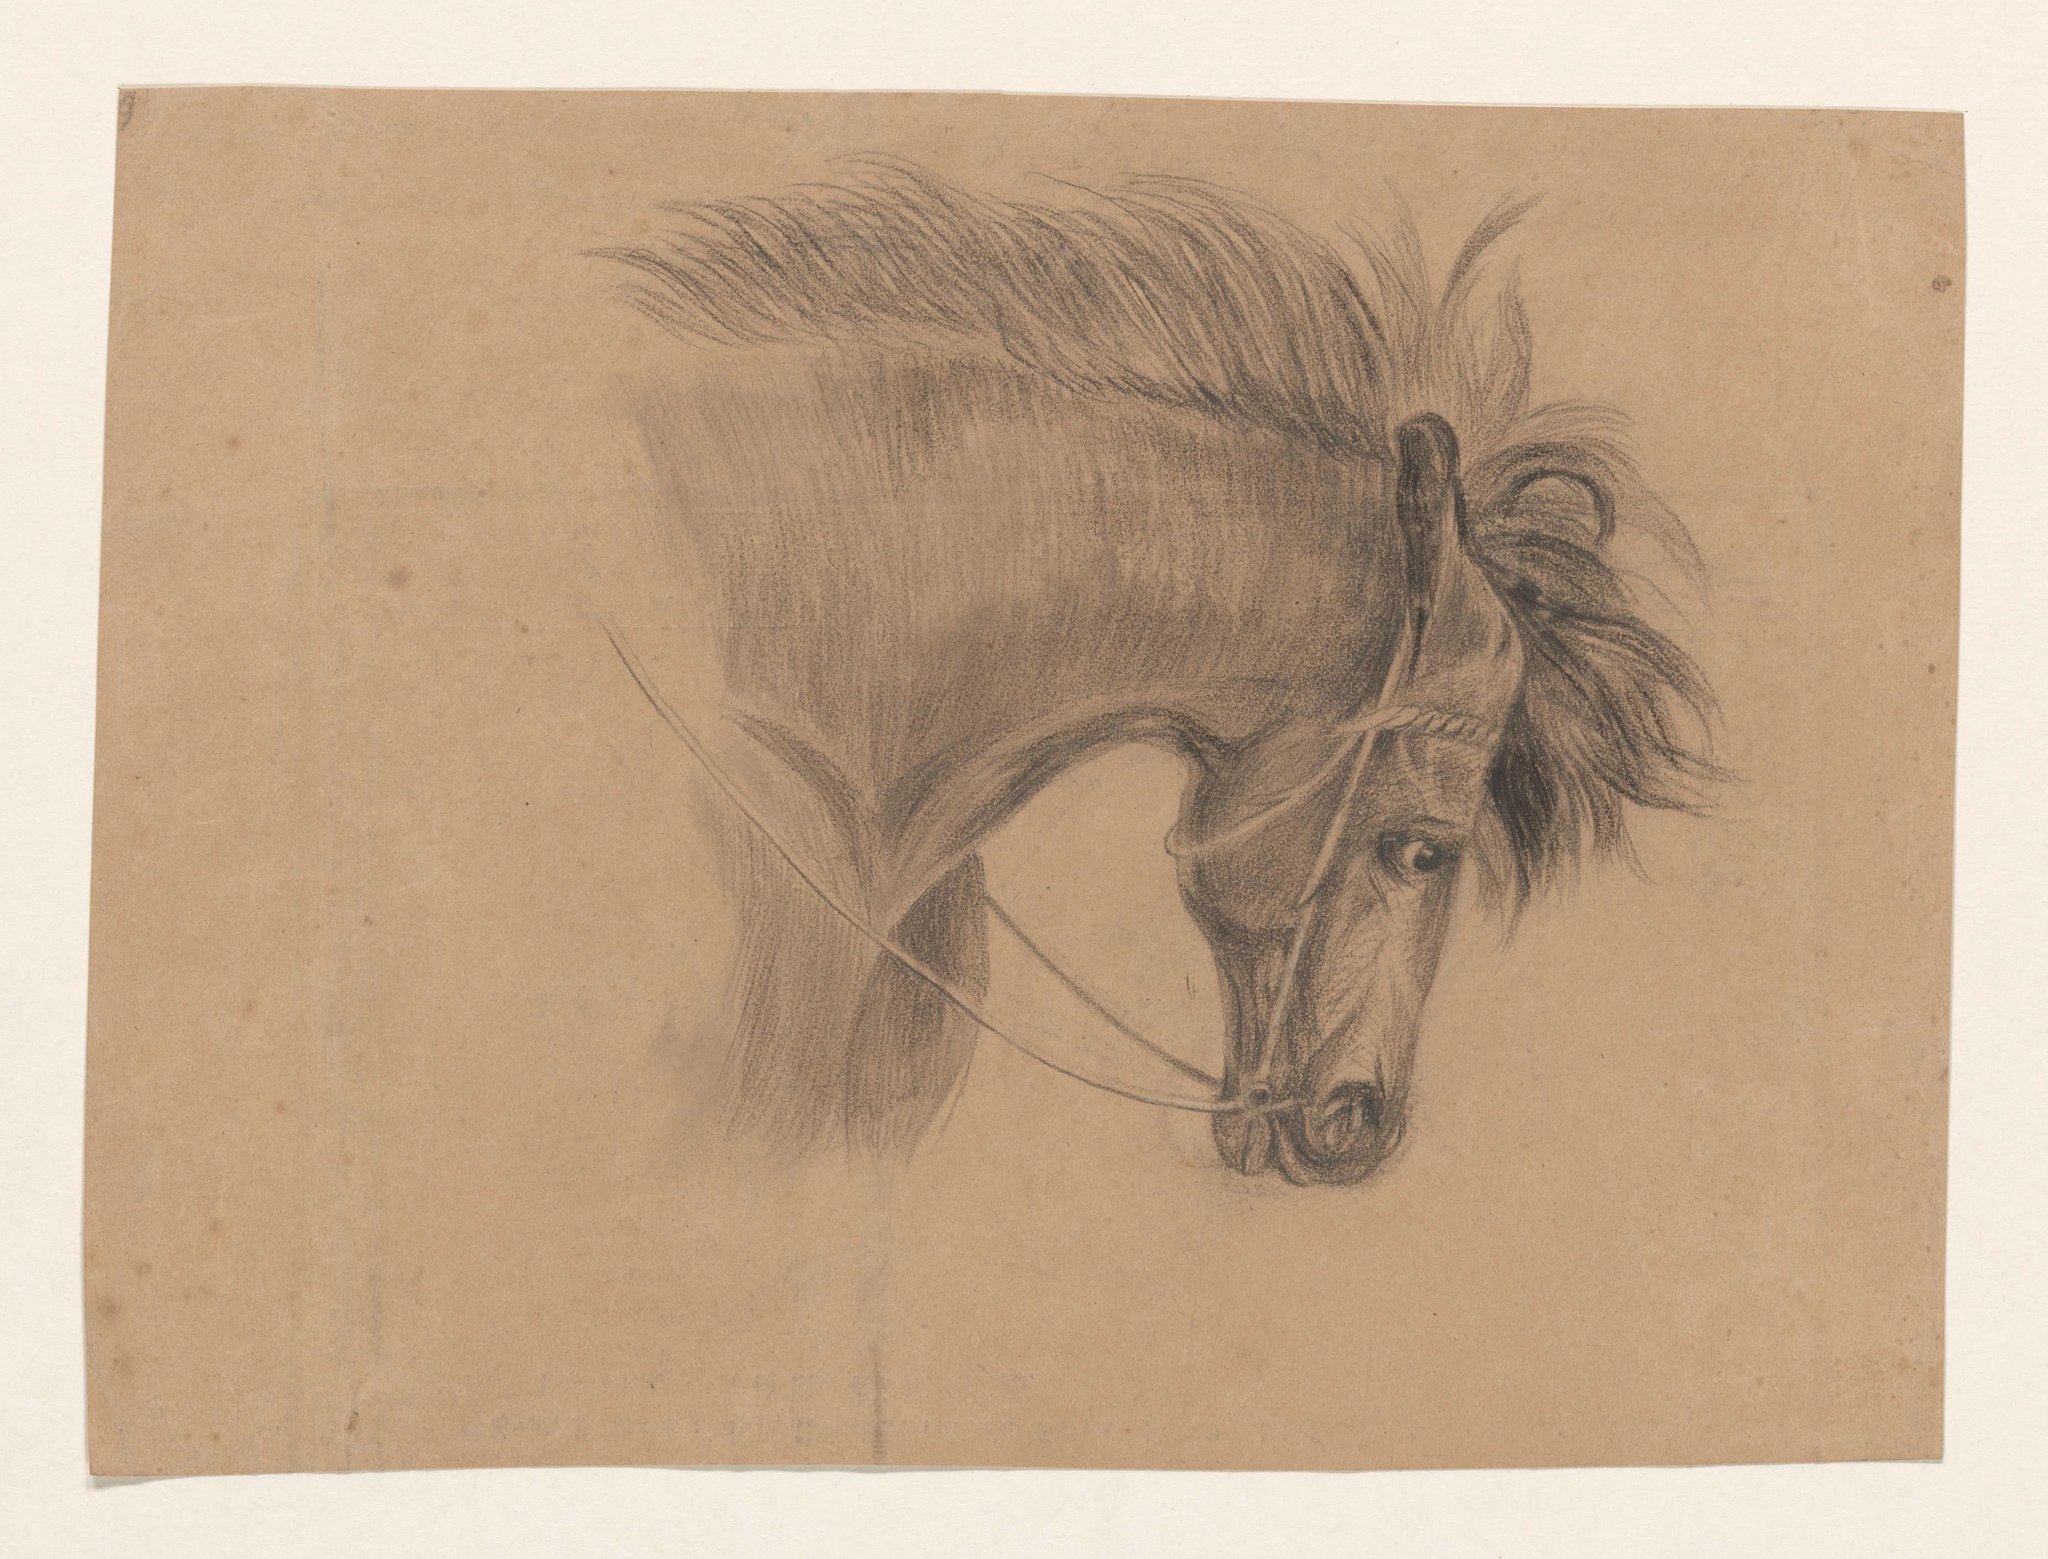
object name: drawing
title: Hoofd van een paard, naar rechts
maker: johannes tavenraat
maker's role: draughtsman, painter, print maker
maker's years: 1809-1881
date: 1819-1881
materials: chalk, paper, pencil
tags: horse